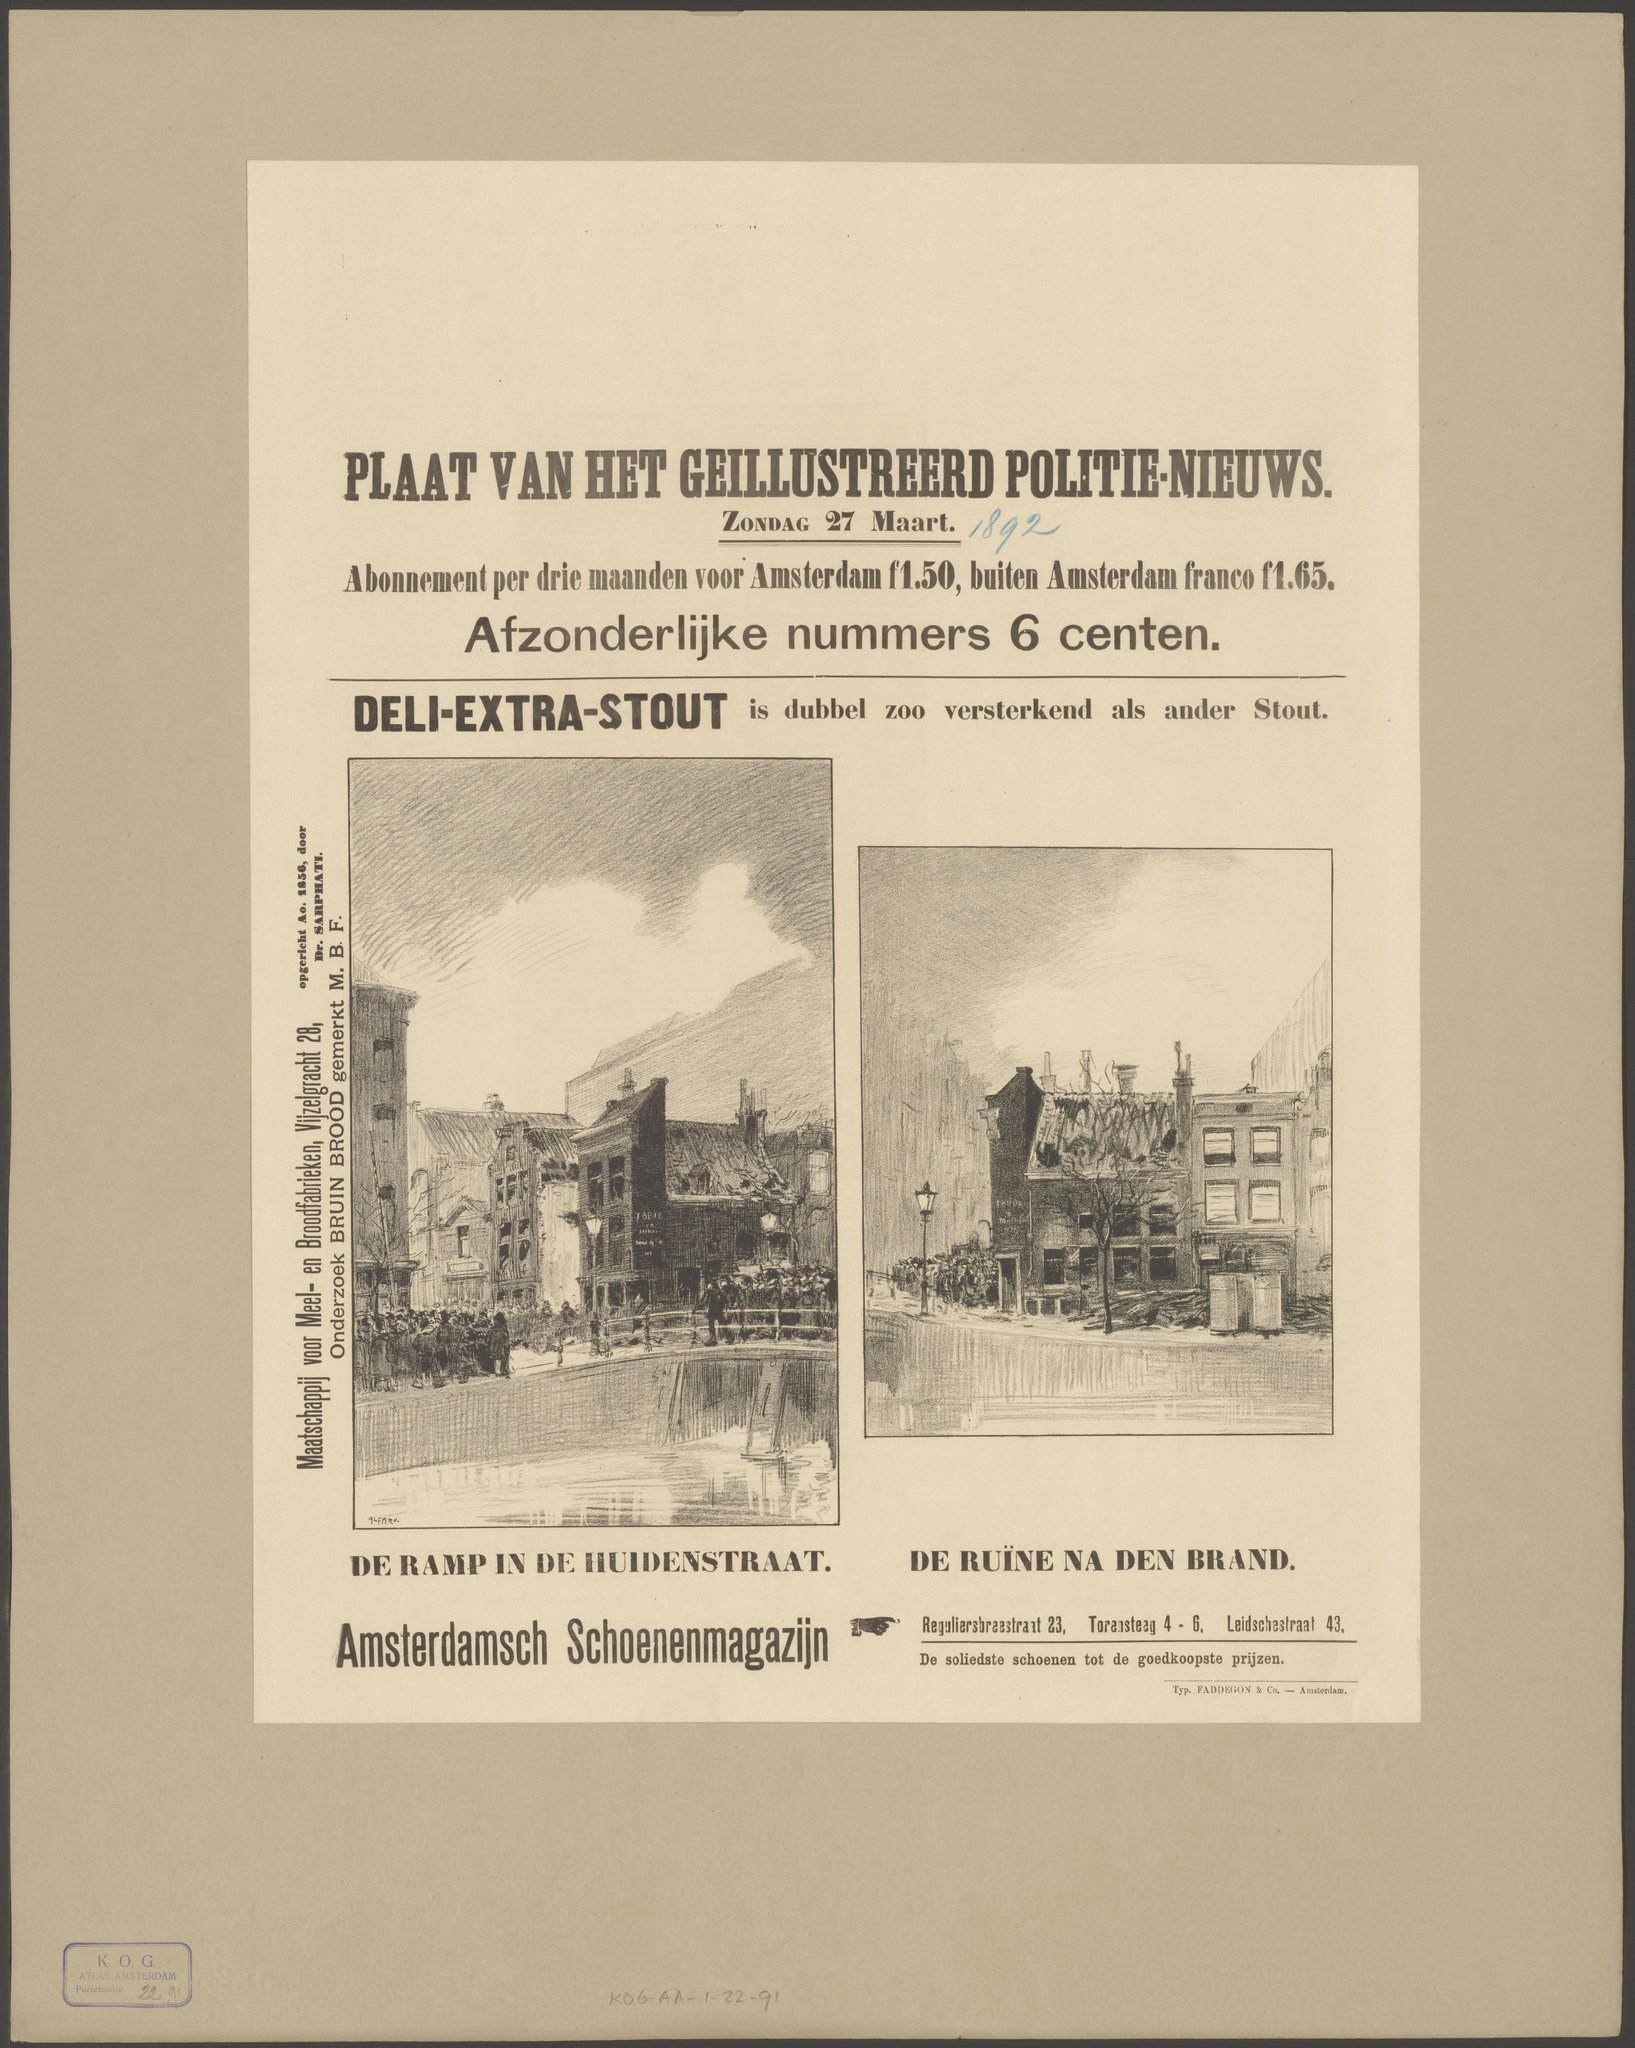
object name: print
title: De ramp in de Huidenstraat / De ruïne na den brand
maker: alfaro reijding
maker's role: draughtsman, engineer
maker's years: 1863-1930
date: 1892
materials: paper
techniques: letterpress printing, lithograph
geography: amsterdam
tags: urban housing, ruin of a building ~ architecture, bridge in city across river, canal, etc.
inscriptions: collector's mark: Lugt 1641b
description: Onderwerpsrubriek binnen de Atlas Amsterdam: Gemeentewerken: B. Branden in particuliere gebouwen.